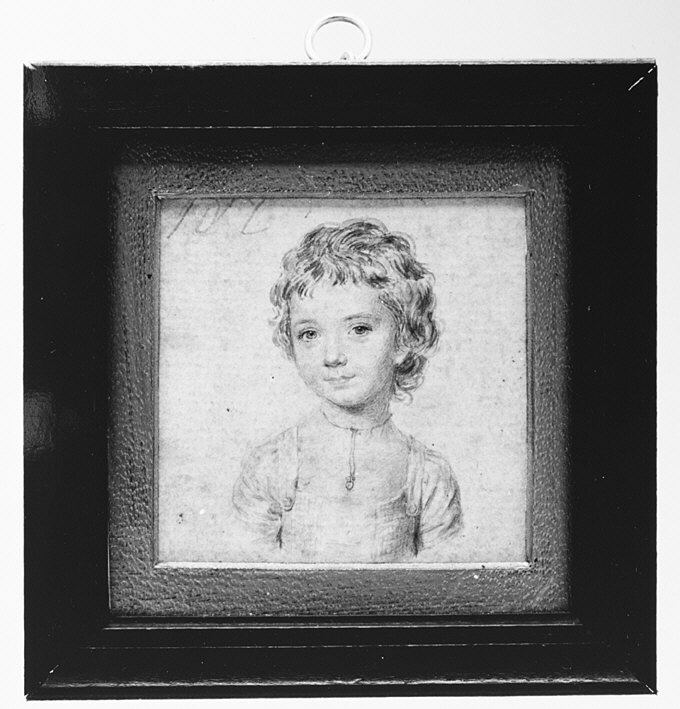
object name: painting, miniature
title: Sir George Armytage (1761–1836), Fourth Baronet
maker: john smart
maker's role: artist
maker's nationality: british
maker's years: 1741-1811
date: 1763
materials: paper, pencil, watercolor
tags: boys,portraits